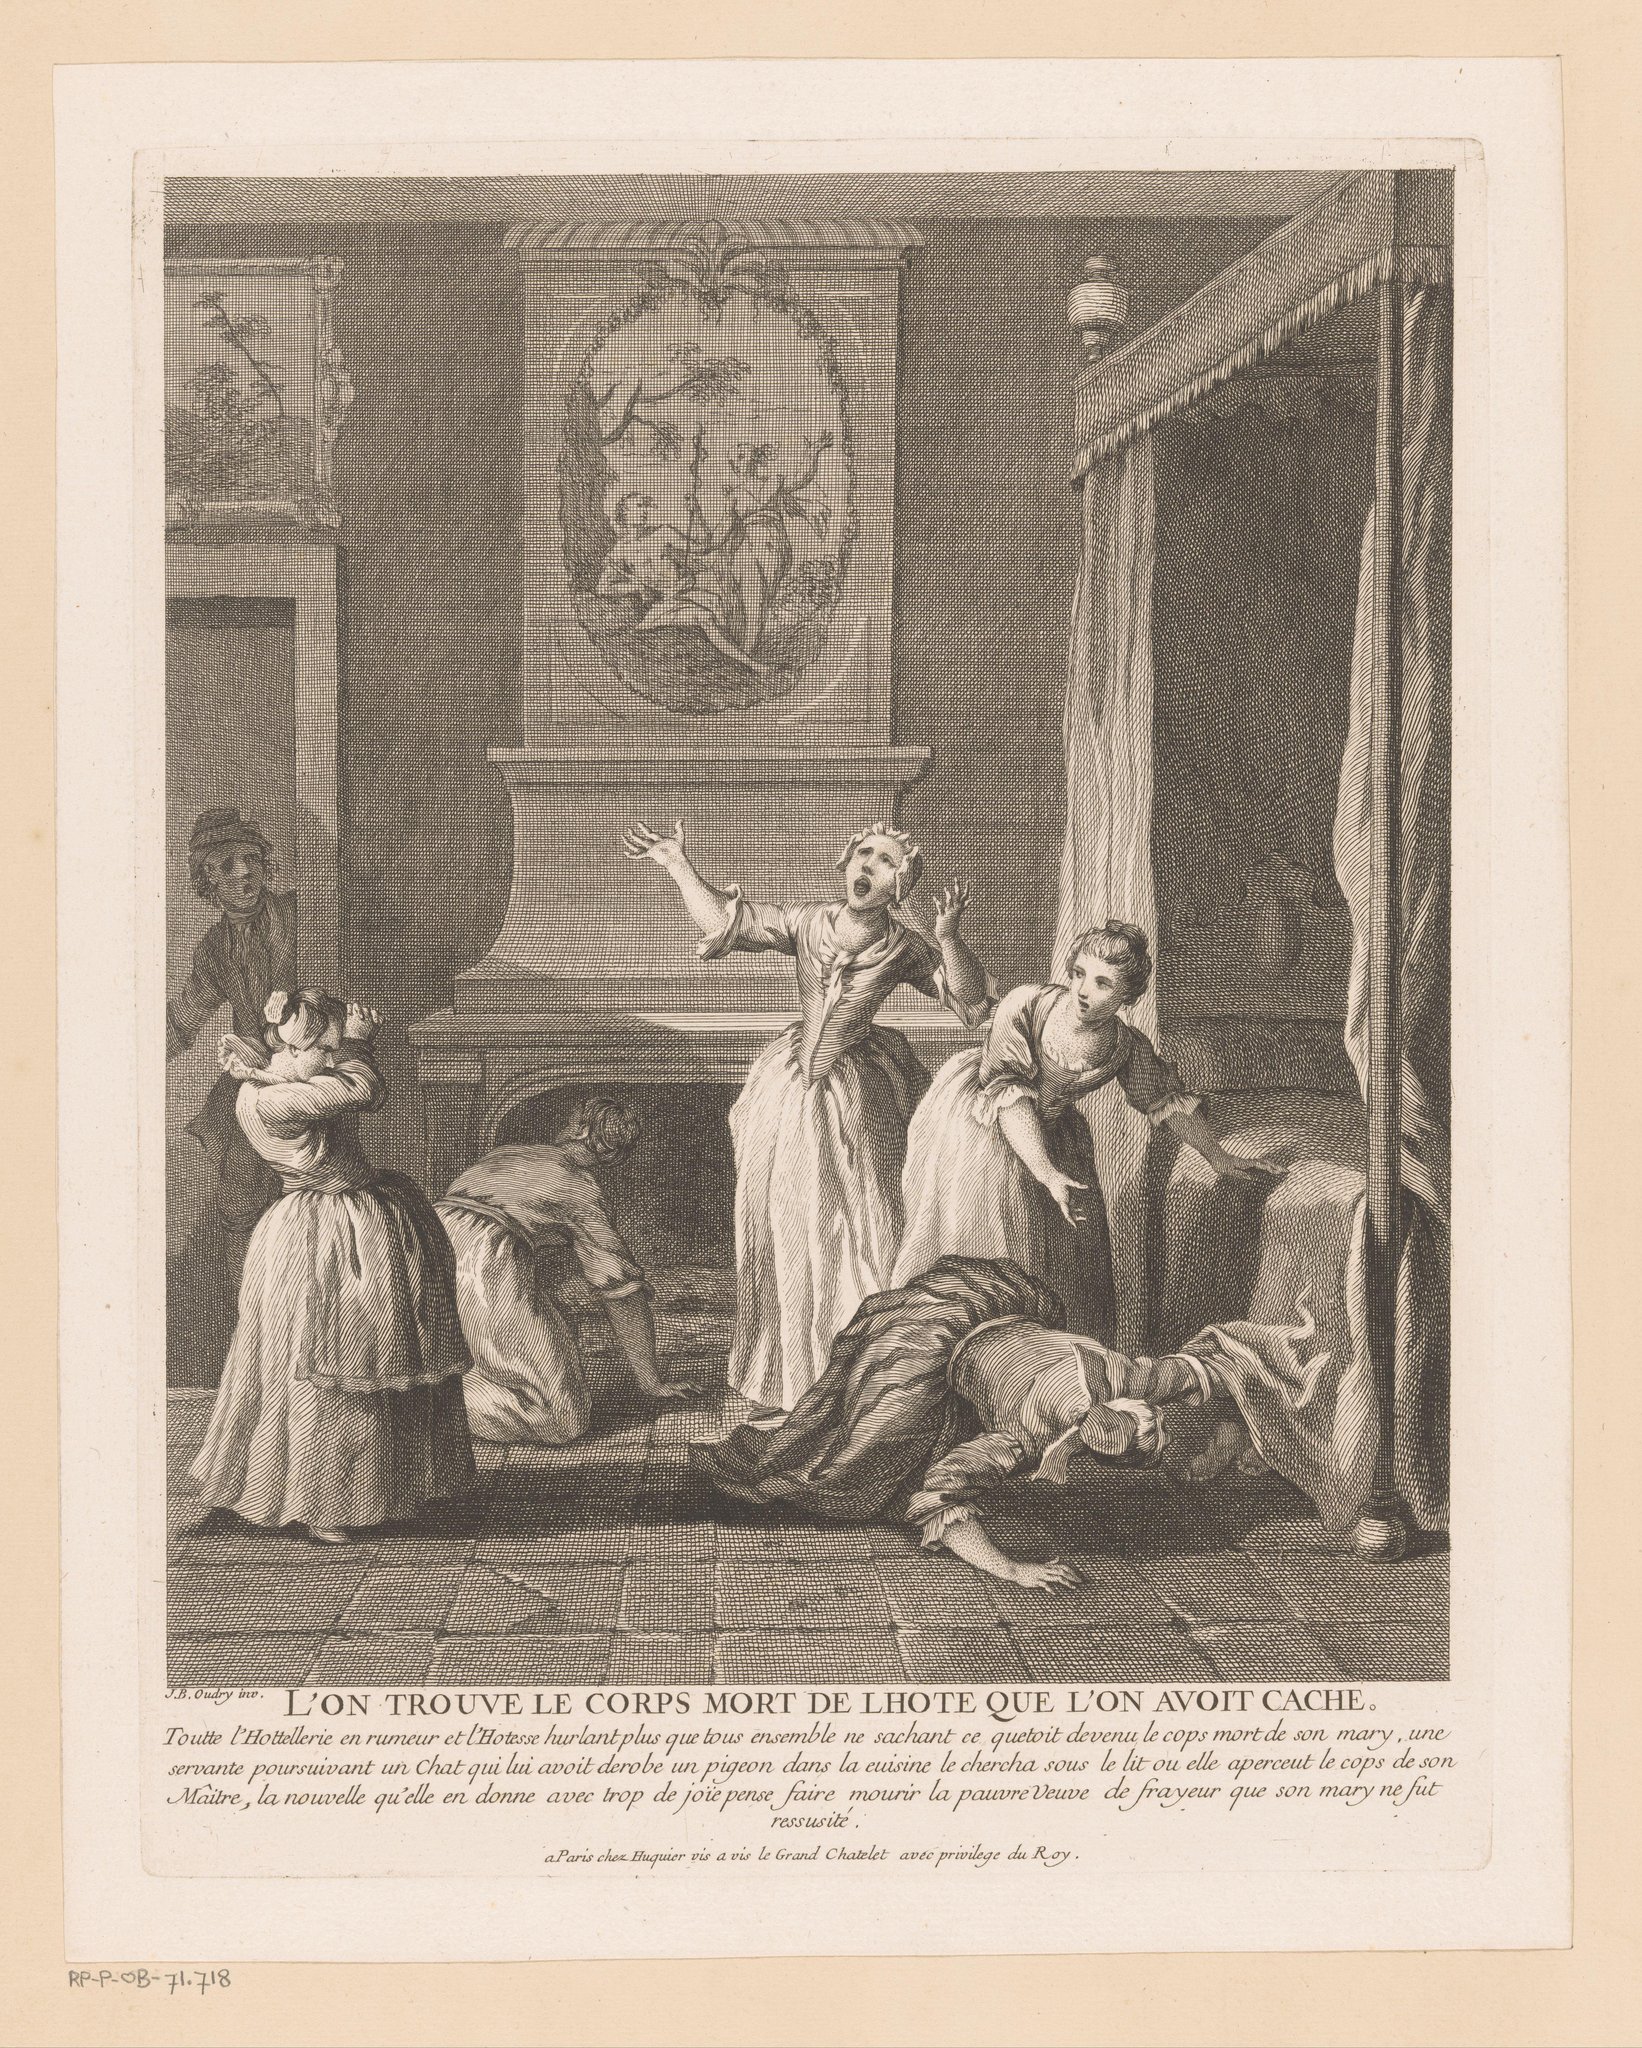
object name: print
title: Scènes uit de Roman Comique van Scarron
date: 1705-1772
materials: paper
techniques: engraving, etching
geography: france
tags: finding a dead person, (scarron, roman comique) specific works of literature (with author, title)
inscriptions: collector's mark: Lugt 240